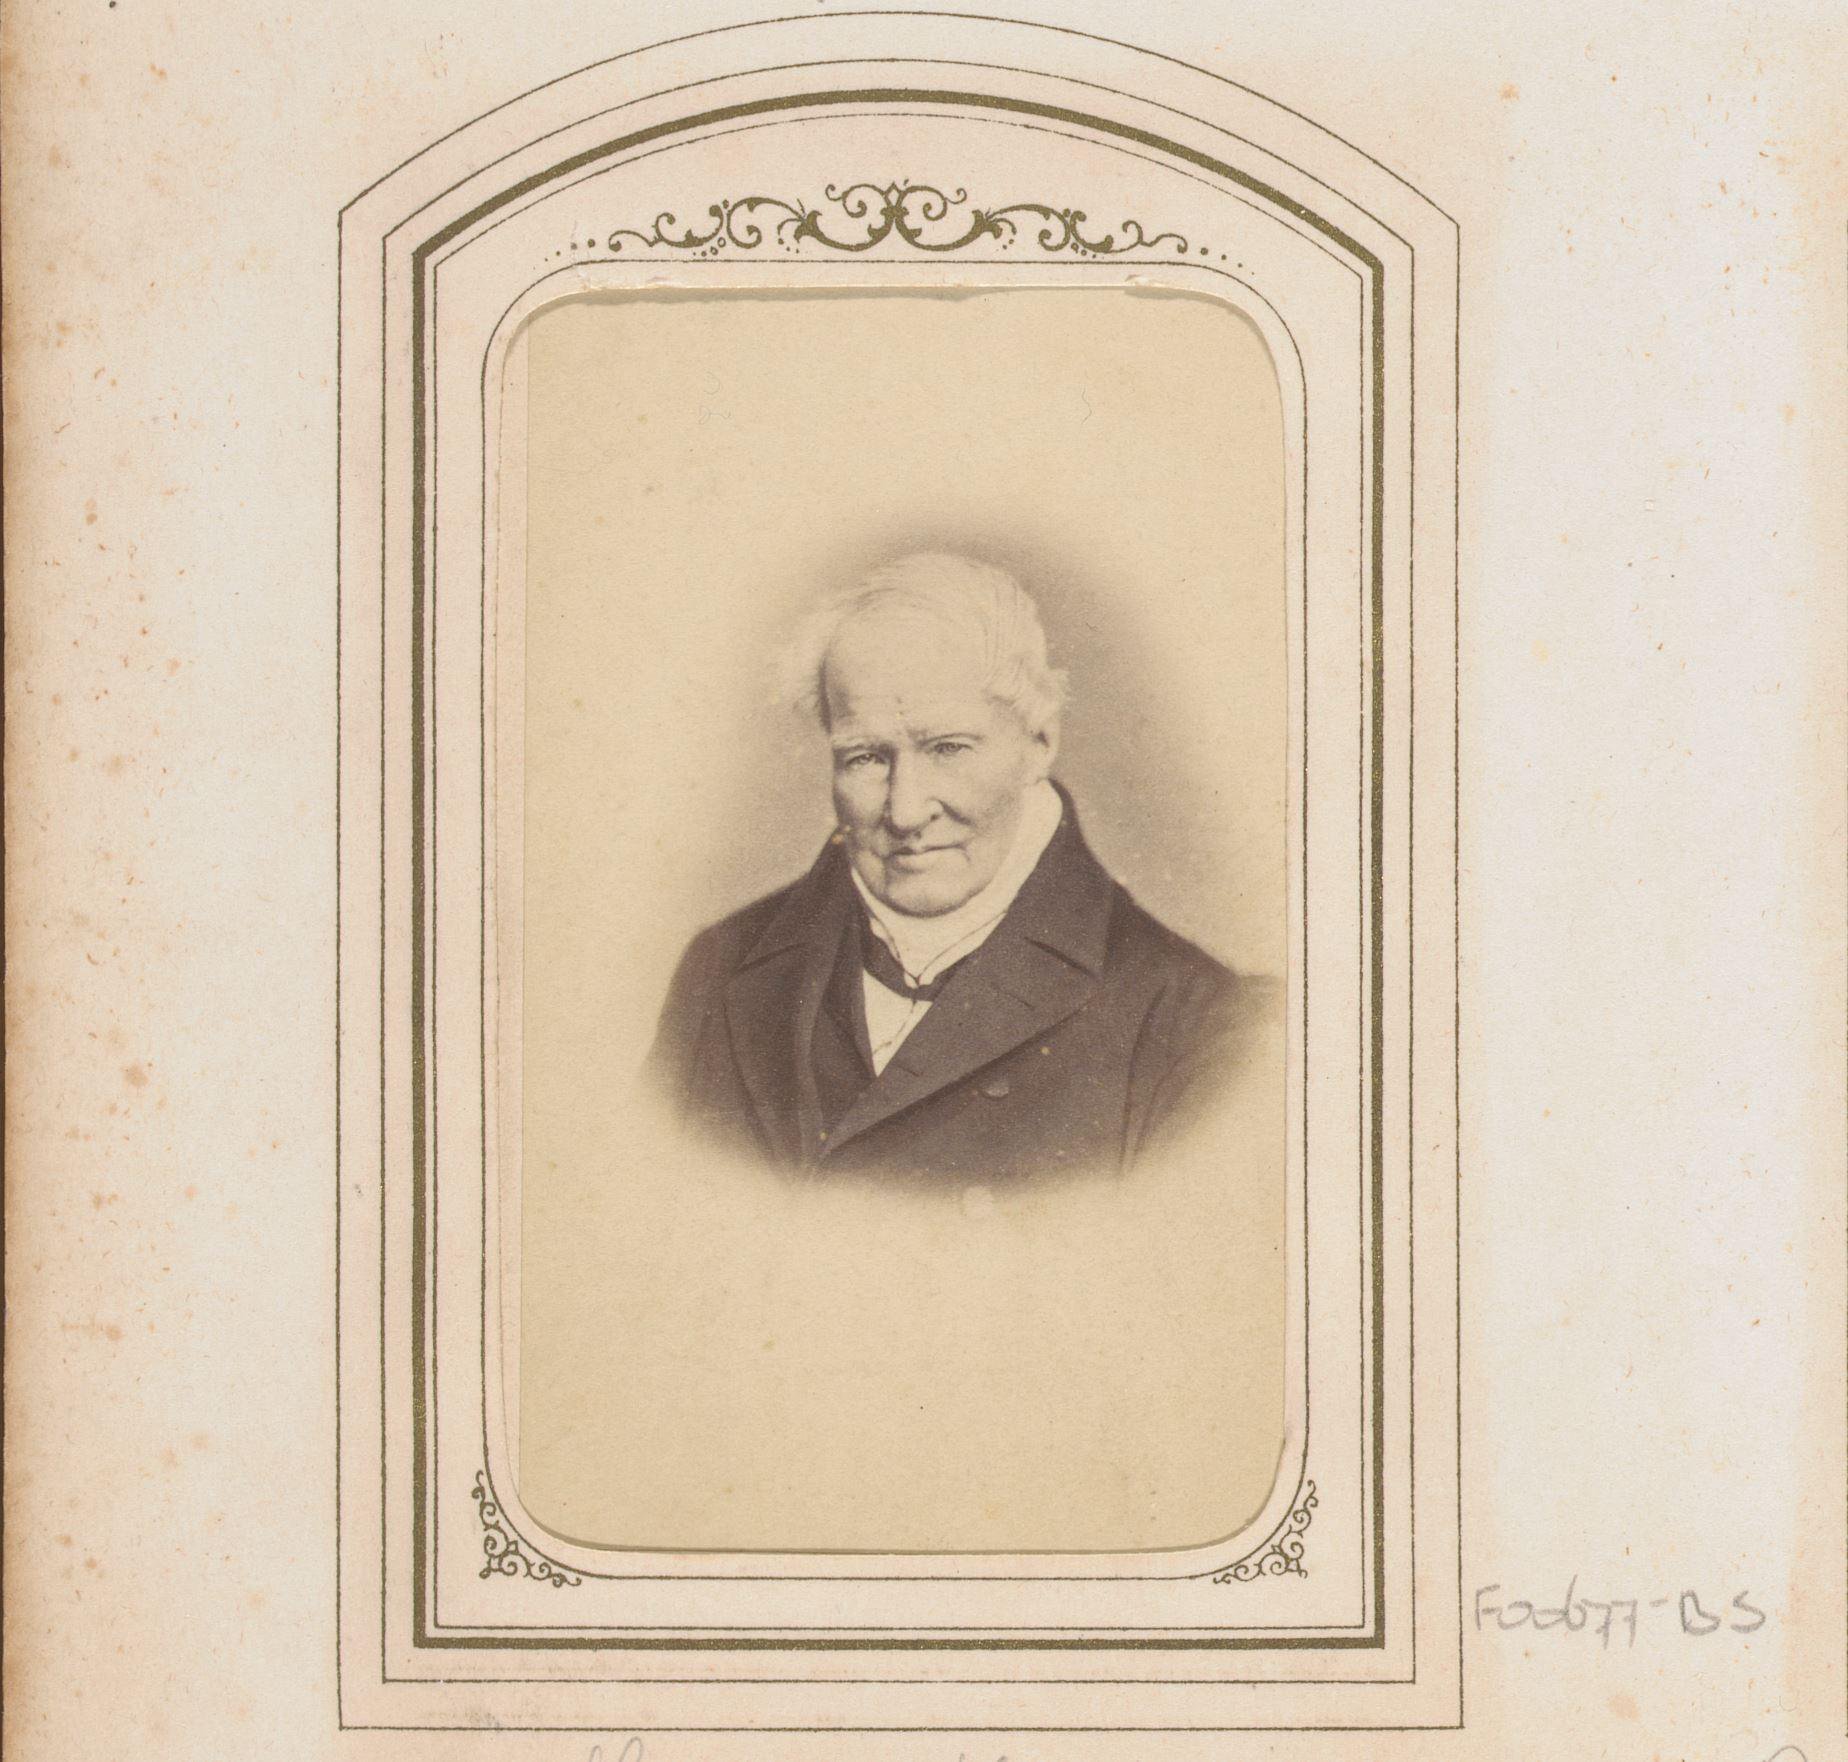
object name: album leaf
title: Portret van Alexander von Humboldt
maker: e. linde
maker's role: publisher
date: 1855-1859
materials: cardboard, photographic support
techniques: albumen print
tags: berlin, traveler, historical persons, explorer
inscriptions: inscription: ‘E. LINDE's Dépôt./ Photogr. Kunstverlag./ Berlin. London.’, annotation: ‘Alex. von Humboldt/ 1769-1859’, number: ‘25’